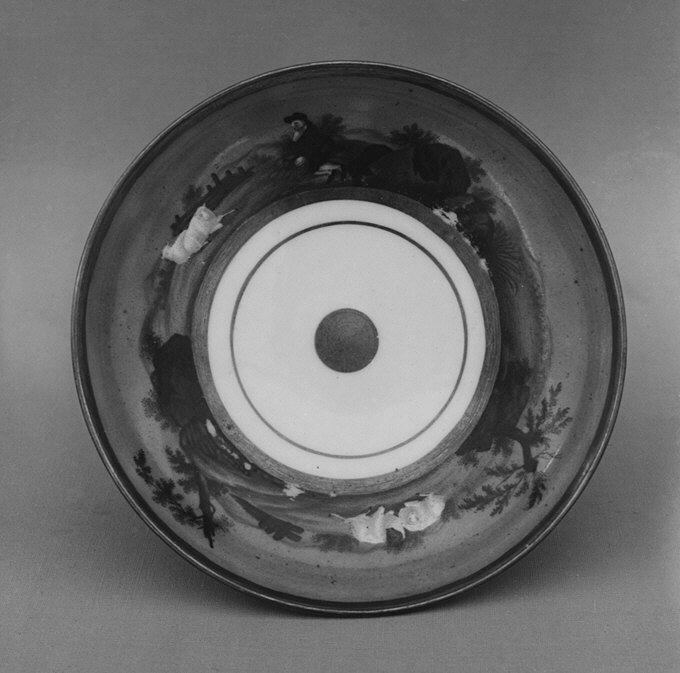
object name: saucer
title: Saucer (one of six) (part of a set)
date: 1820-1830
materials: hard paste porcelain